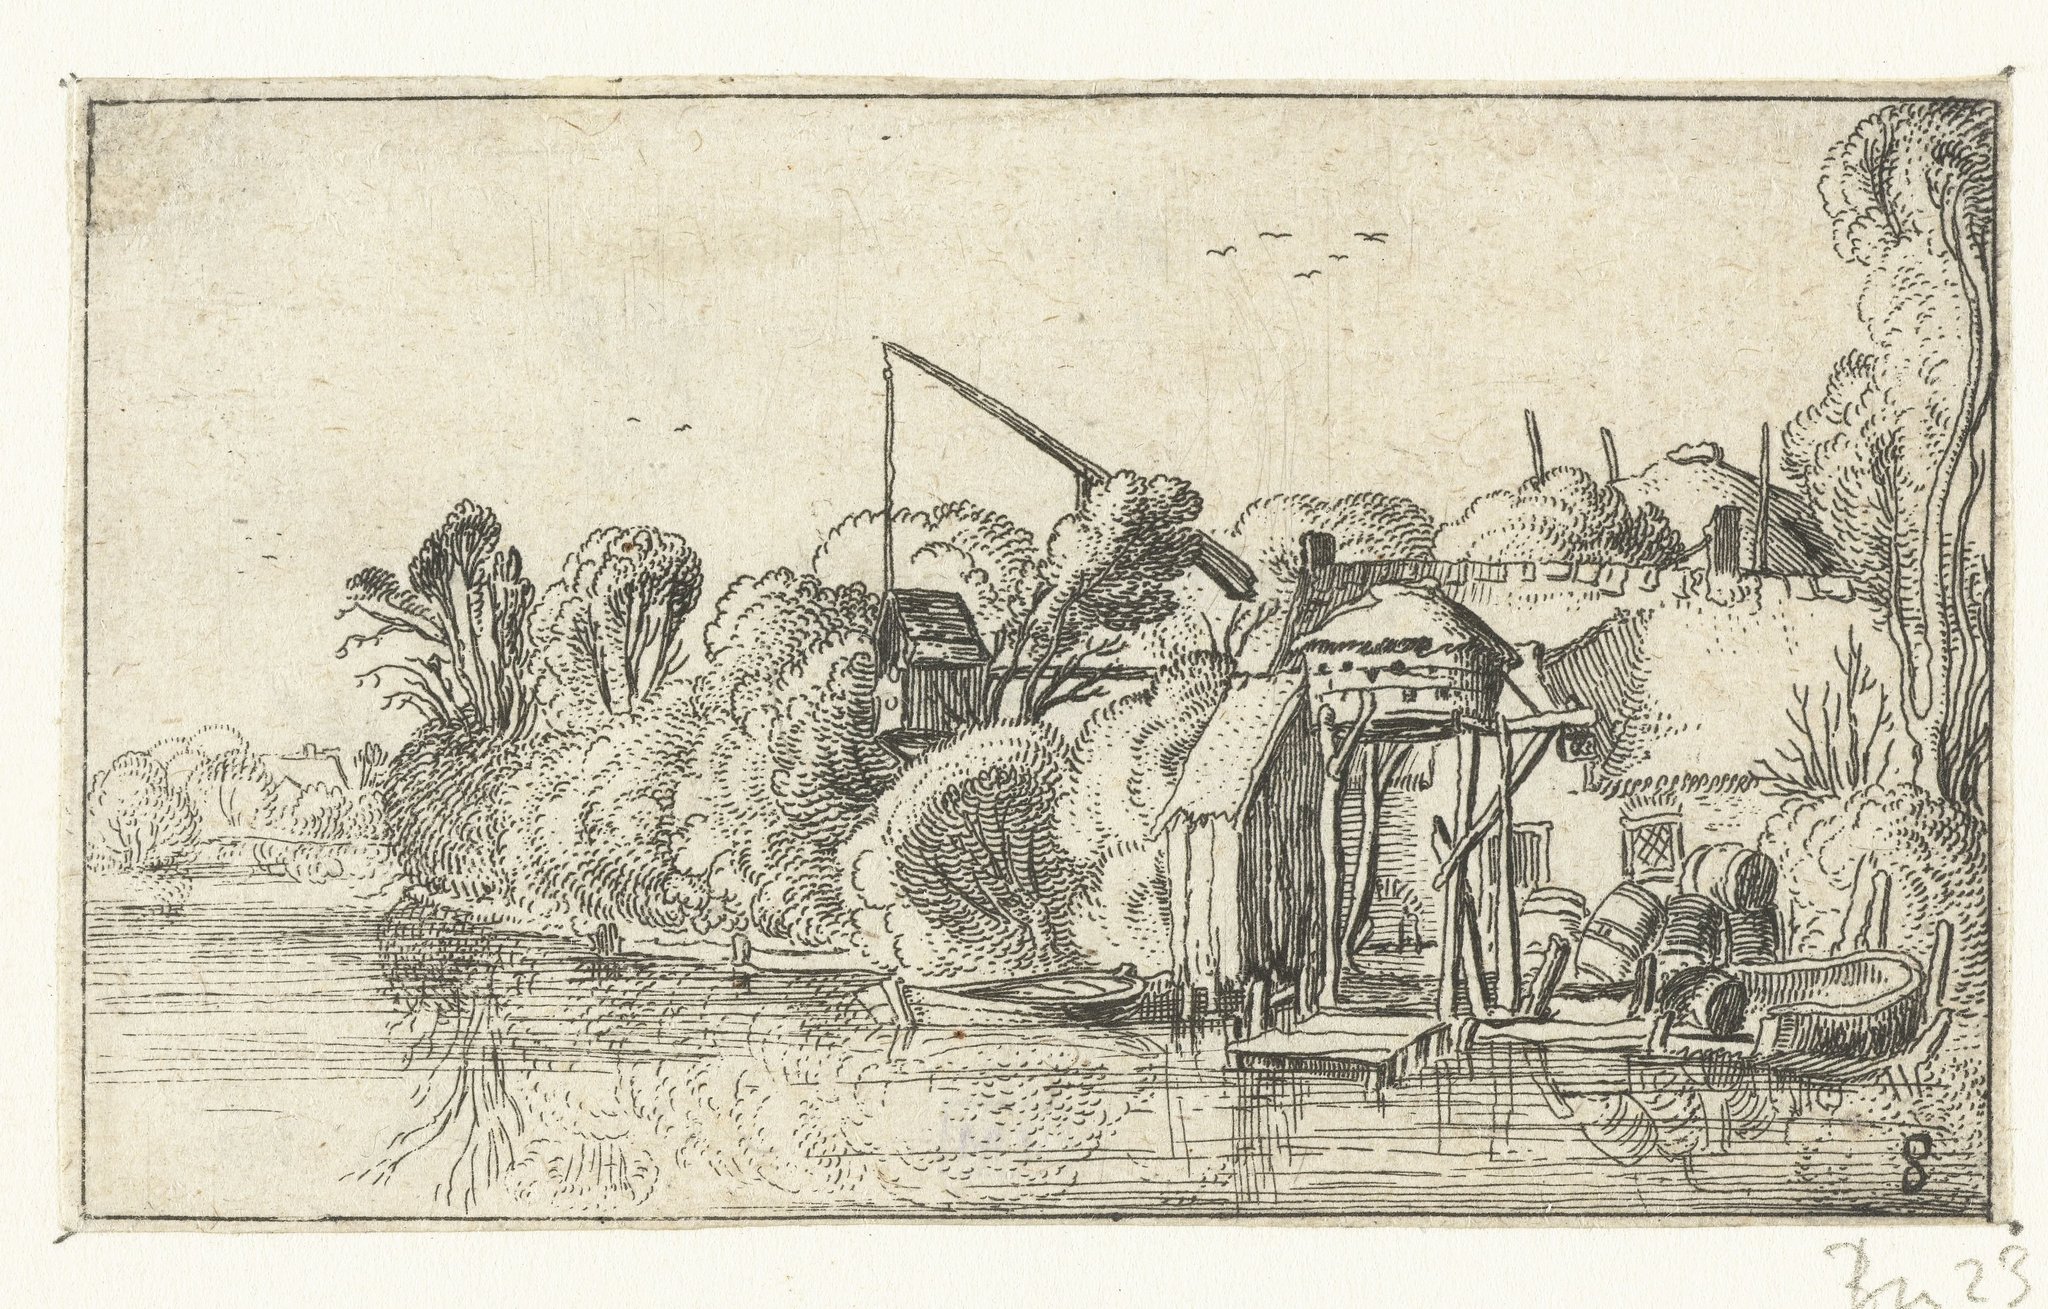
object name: print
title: Brouwerij aan de oever van een rivier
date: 1614-1617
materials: paper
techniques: etching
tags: factories and mills in landscape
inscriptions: collector's mark: Lugt 2227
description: Kopie in spiegelbeeld naar een prent van Esaias van de Velde op een iets kleiner formaat. Kort na de uitgave van de serie met zeven kleine landschappen van Van de Velde verscheen op initiatief van dezelfde uitgever een serie van zestien landschappen naar zijn werk. Twee landschappen uit deze reeks waren kopieën naar Van de Velde's prenten waaronder dit landschap met een brouwerij.